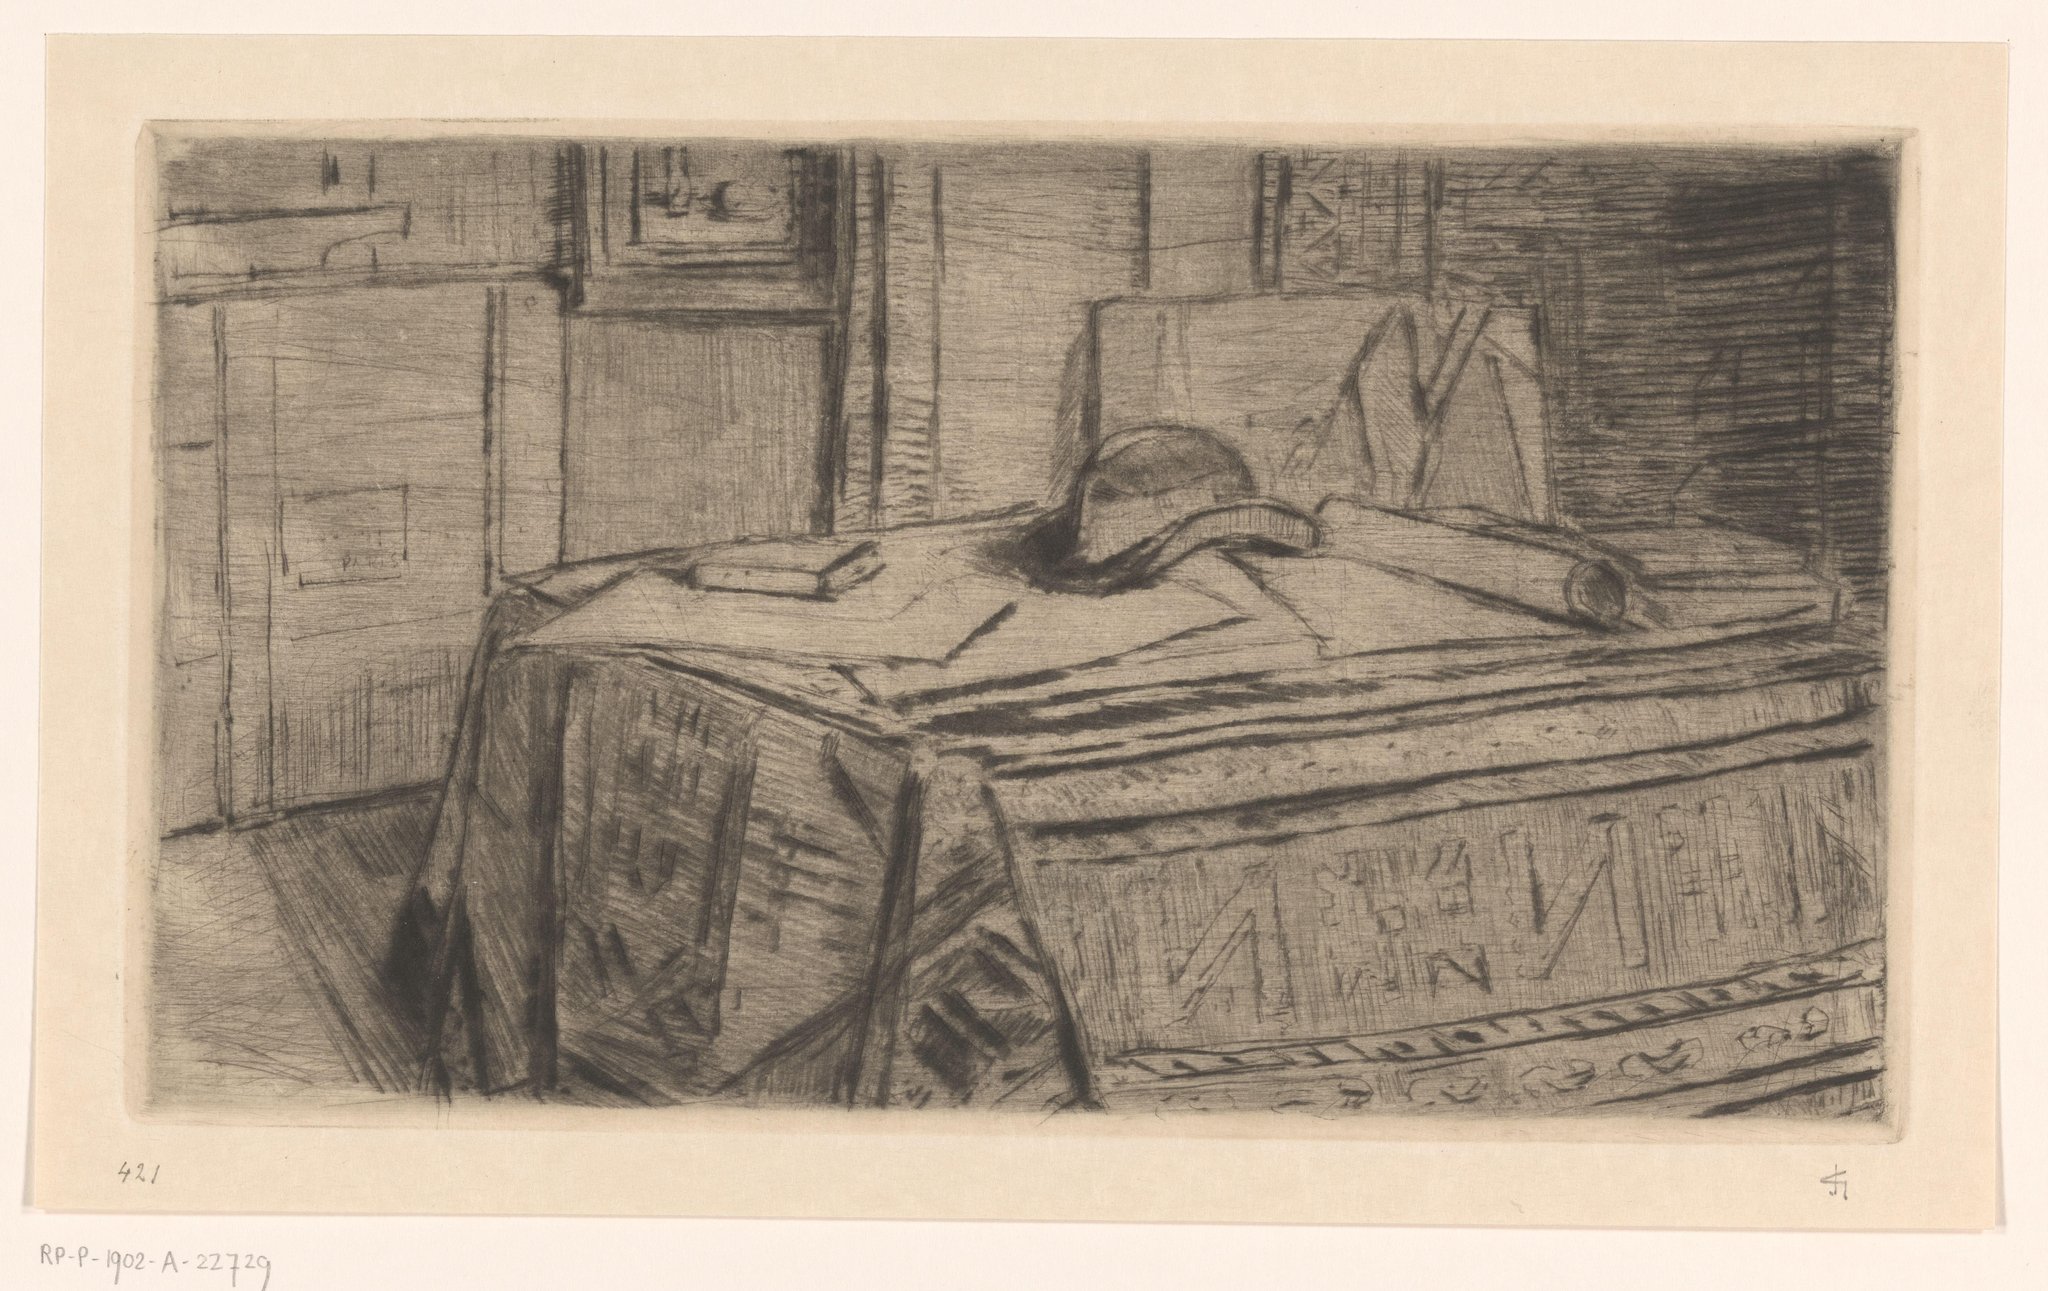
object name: print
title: Papieren en een hoed op een tafel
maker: carel nicolaas storm van s-gravesande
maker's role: draughtsman, print maker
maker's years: 1841-1924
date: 1851-1902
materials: paper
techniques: drypoint, intaglio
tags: writing-table, writing-desk, head-gear: hat, communal rooms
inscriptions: number: ‘421’, collector's mark: Lugt 2228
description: Mogelijk vermeld in: Storm van 's-Gravesande, Charles. Catalogue des eaux-fortes et lithographies. New York: s.n., 1903, of in een onbekende latere uitgave van het manuscript. Vermoedelijk vermeld als catalogusnummer 421.